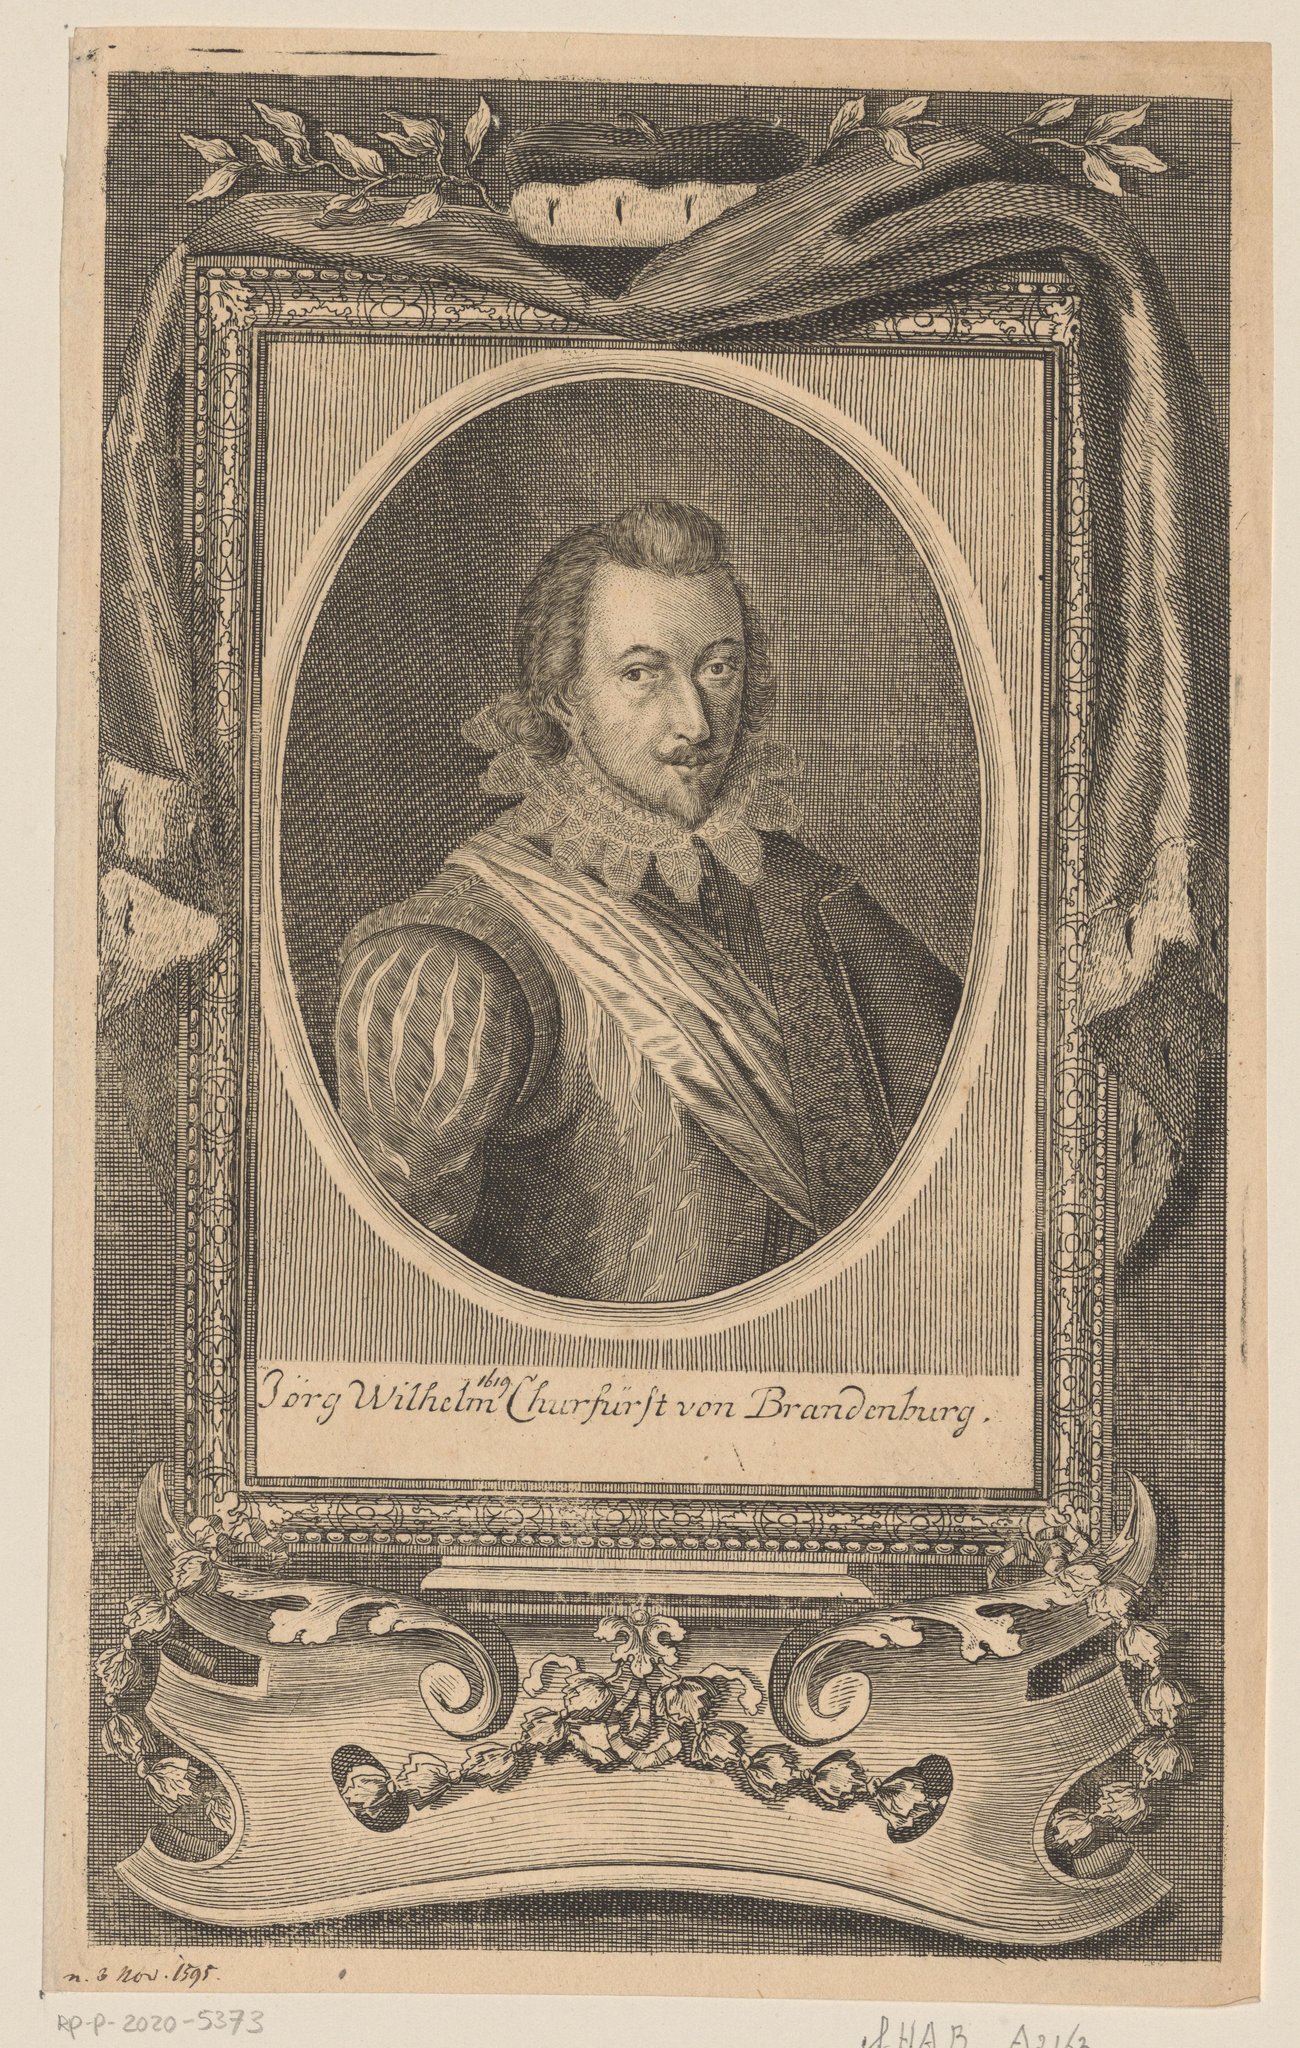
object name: print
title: Portret van Georg Wilhelm van Brandenburg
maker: Anonymous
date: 1721-1722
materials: paper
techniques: engraving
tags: historical persons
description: Prent mogelijk uit: Conterfet-Kupferstich soviel man deren zu handen bringen können. 2 dln. Leipzig: Moritz Georg Weidmann, [1721-1722].